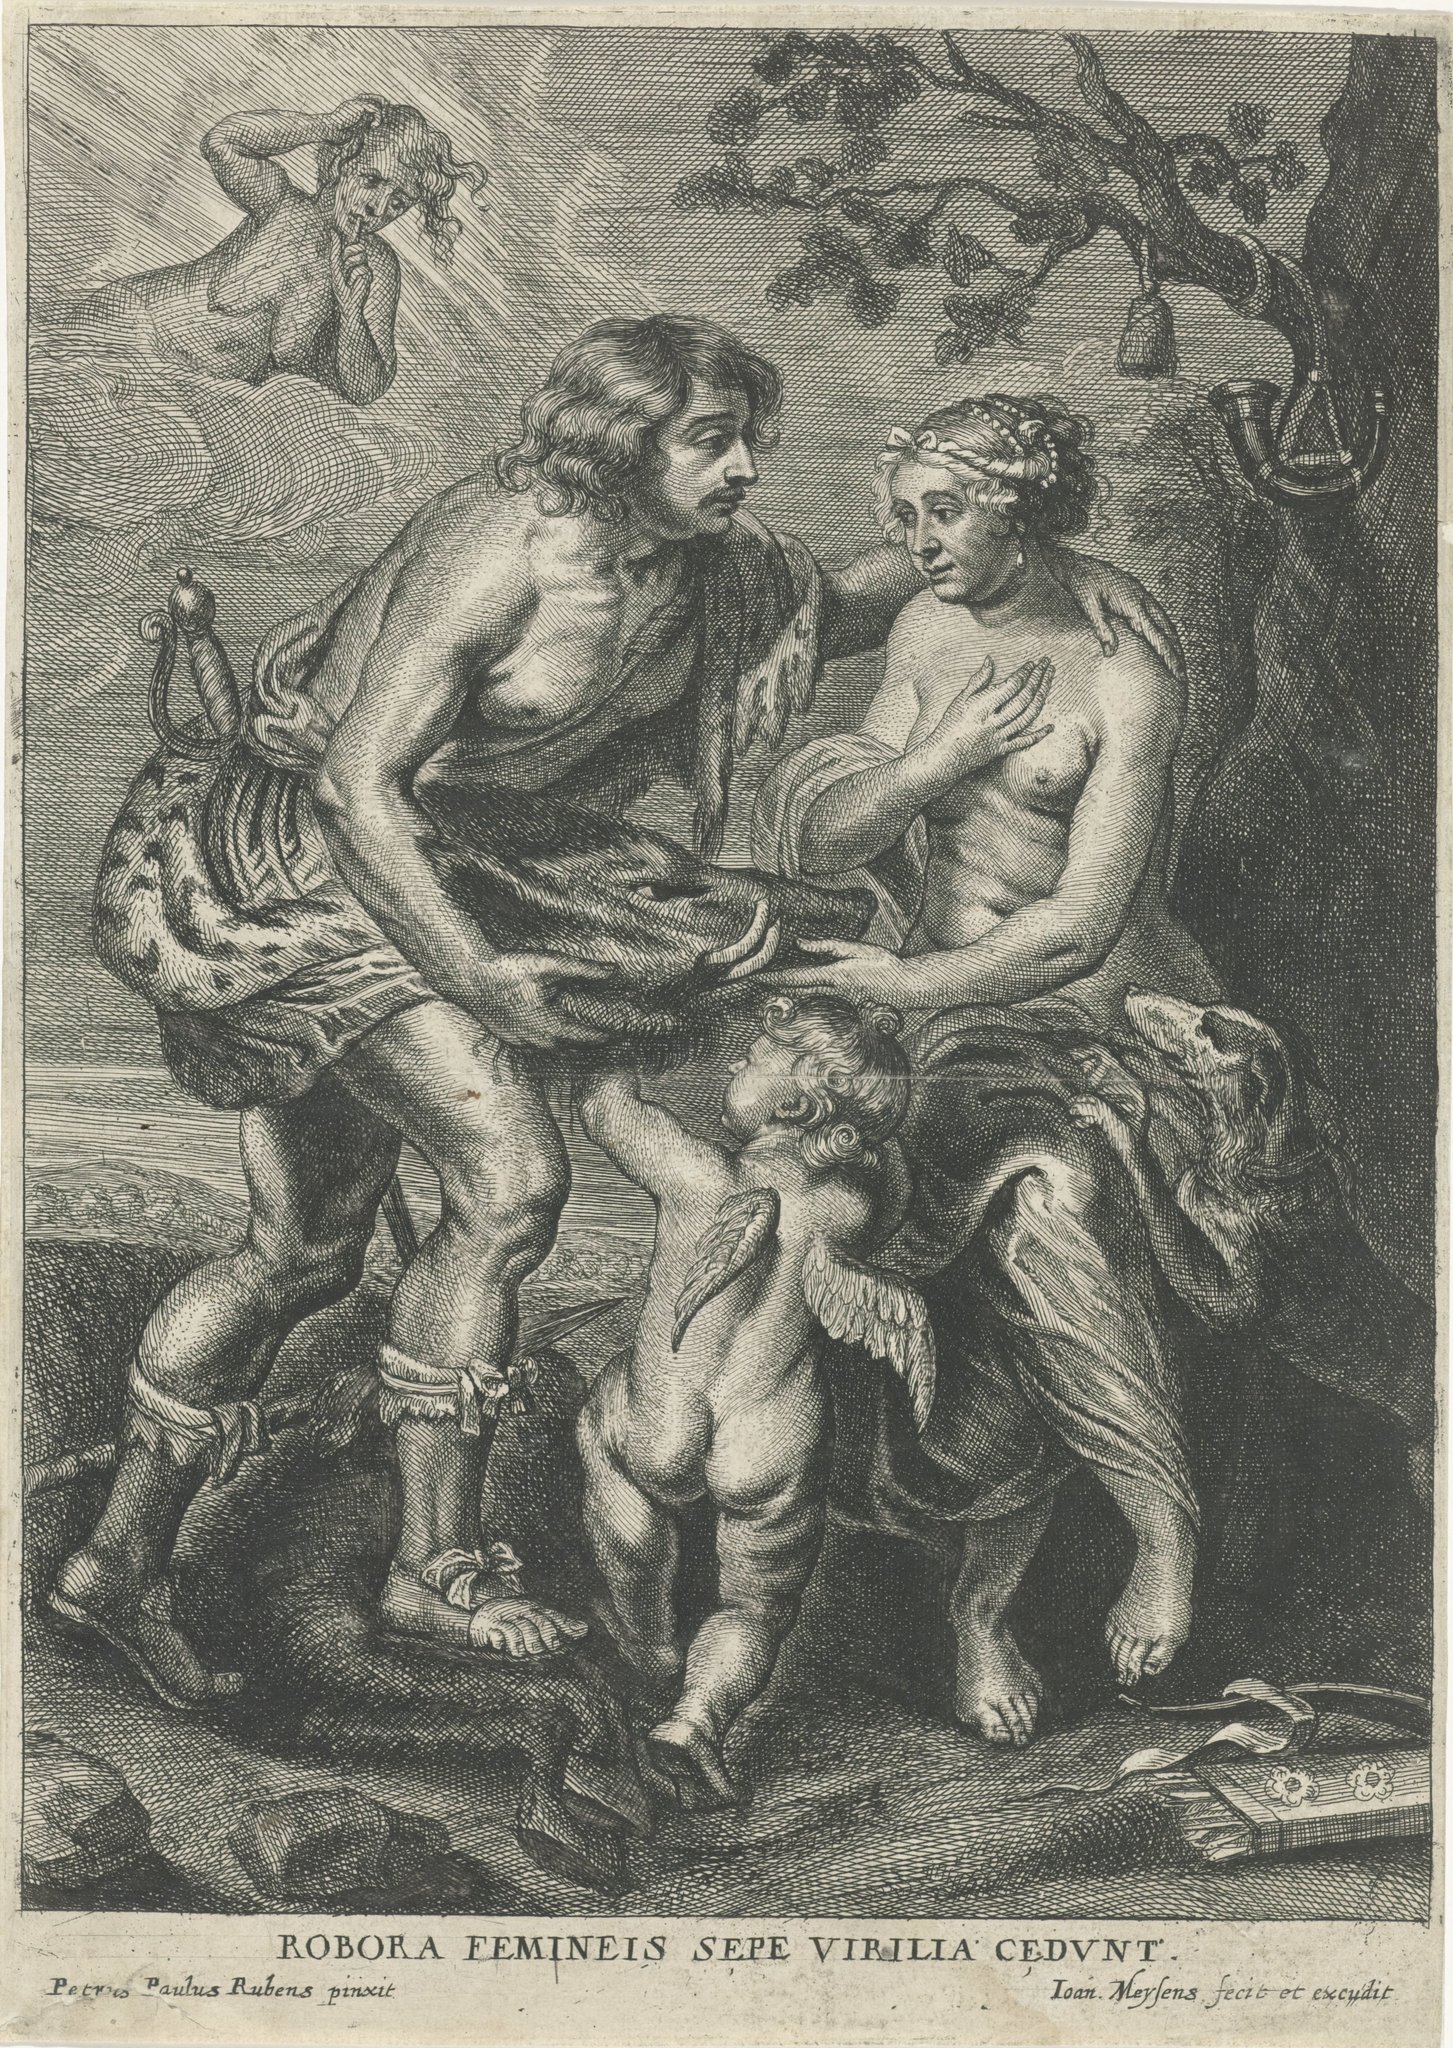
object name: print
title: Robora femineis sepe virilia cedunt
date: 1640-1670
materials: paper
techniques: engraving, etching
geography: antwerp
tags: hunting dogs, (story of) cupid, amor (eros), meleager gives the head of the boar to atalanta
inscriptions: collector's mark: Lugt 240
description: Meleager geeft de kop en de huid van het gedode wilde zwijn aan zijn geliefde Atalante. Tussen hen staat Amor. Op de wolken kijkt een godin toe. Naast Atalante een jachthond, in de boom hangt een jachthoorn.